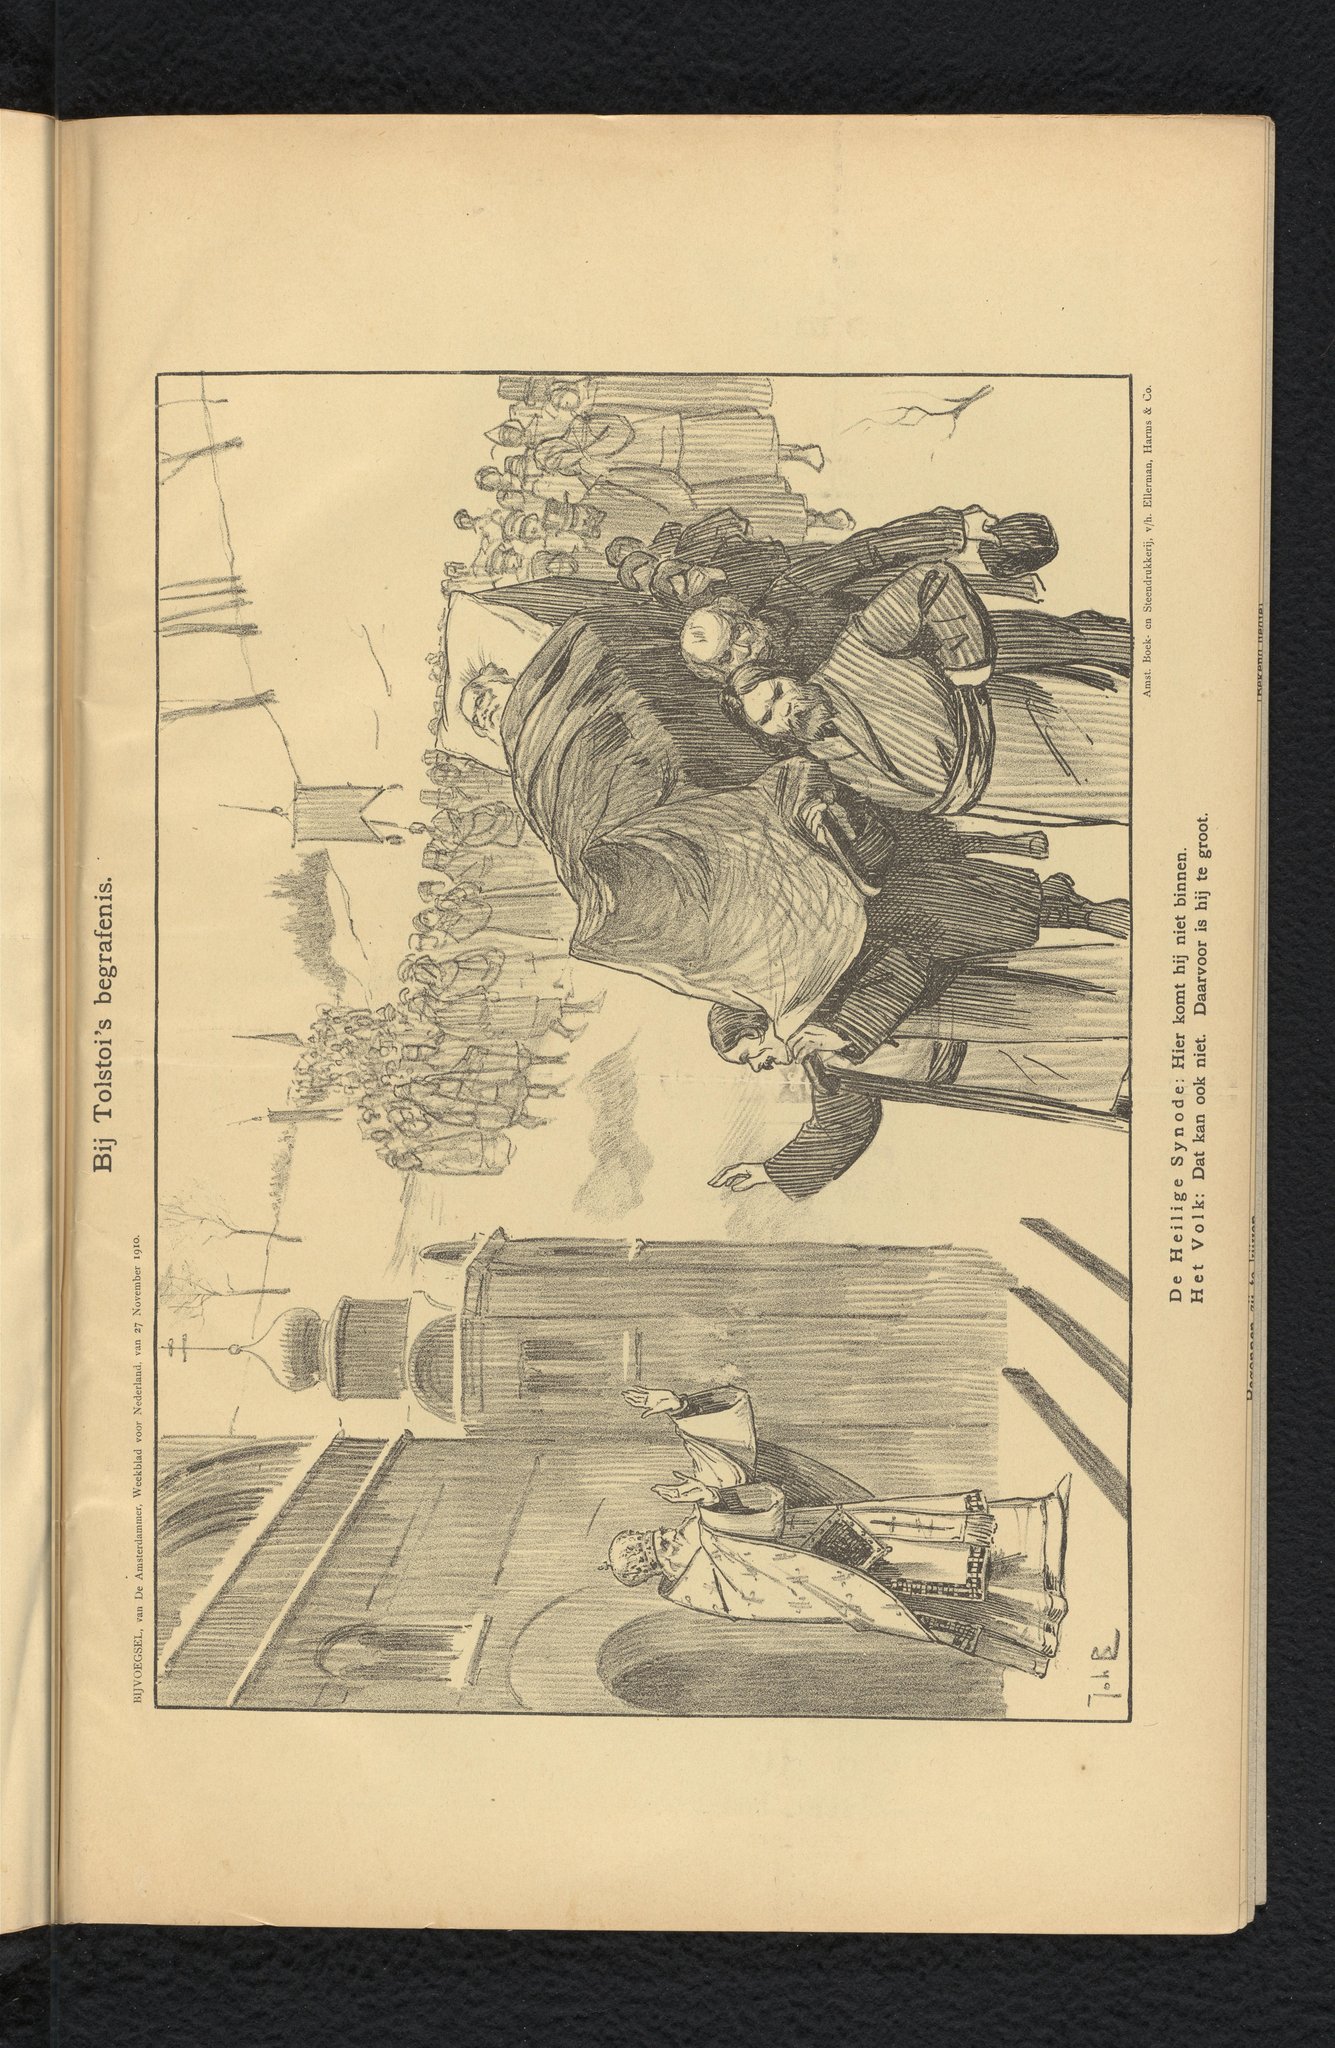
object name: cartoon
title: Bij Tolstoi's begrafenis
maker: johan braakensiek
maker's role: draughtsman, print maker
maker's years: 1858-1940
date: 1910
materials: paper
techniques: lithograph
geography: amsterdam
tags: lev tolstoj, cortege, funeral procession, church (exterior), writer, poet, author, political caricatures and satires, russia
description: De begrafenisstoet van de op 20 november overleden Russische schrijver Leo Tolstoi passeert de orthodoxe kerk. De kerkelijke leider maakt met een afwerend gebaar duidelijk dat hij daar niet naar binnen mag, een drager van de kist antwoordt dat de schrijver te groot is voor de kerk.